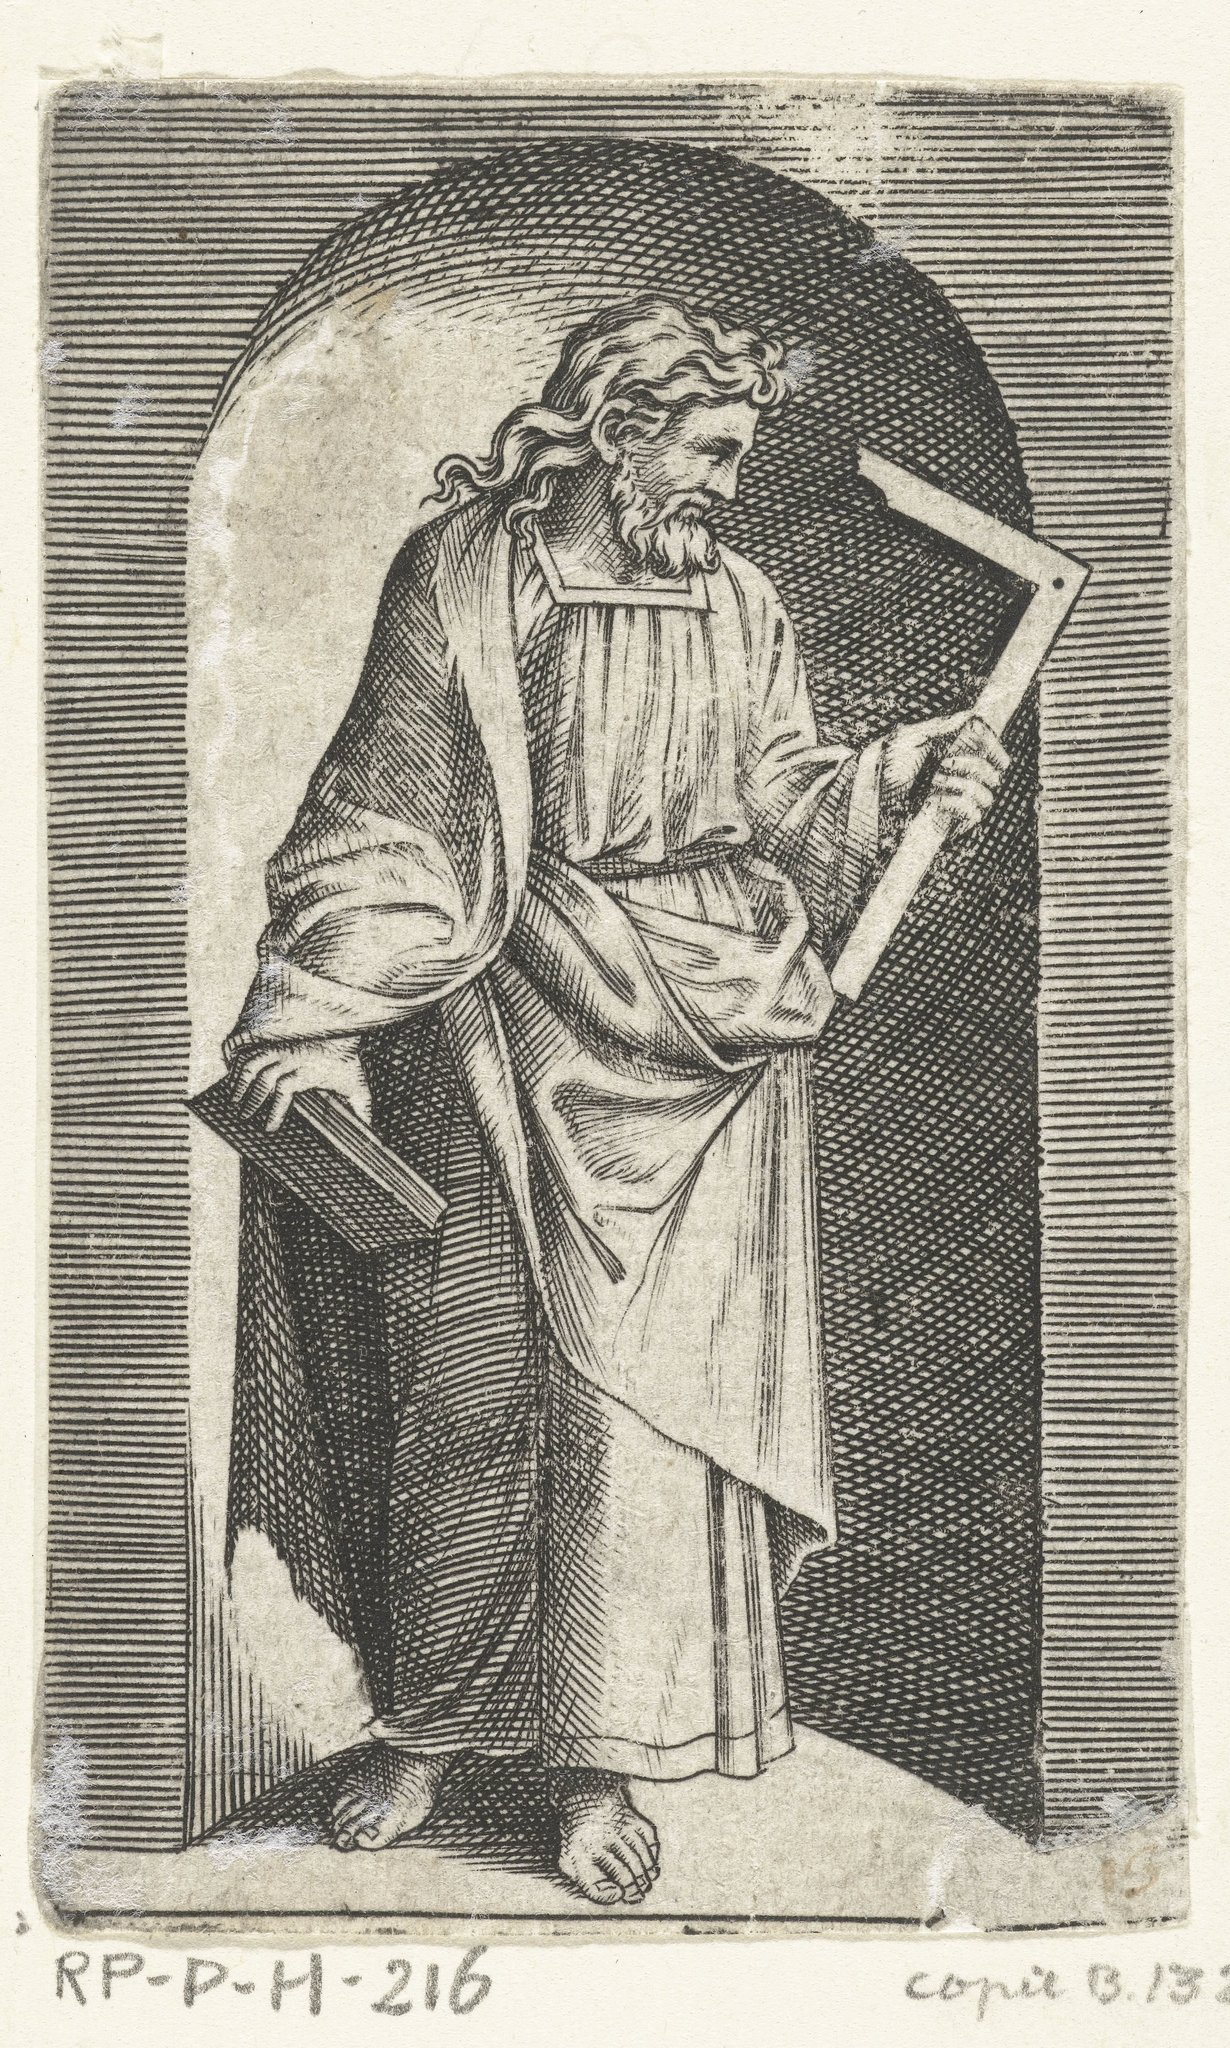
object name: print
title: Christus en de Apostelen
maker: Anonymous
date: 1517-1577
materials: paper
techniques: engraving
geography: italy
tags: the apostle thomas; possible attributes: book, chalice, girdle, heart, lance or spear, scroll, square, stones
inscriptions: collector's mark: Lugt 11, collector's mark: Lugt 10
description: Kopie in spiegelbeeld naar prent van Marcantonio Raimondi. De anonieme prentmaker wijzigde details, hij plaatste de heilige in een nis. Raimondi vervaardigde de serie van dertien kleine prenten van Christus en de apostelen naar ontwerp van Raphael.